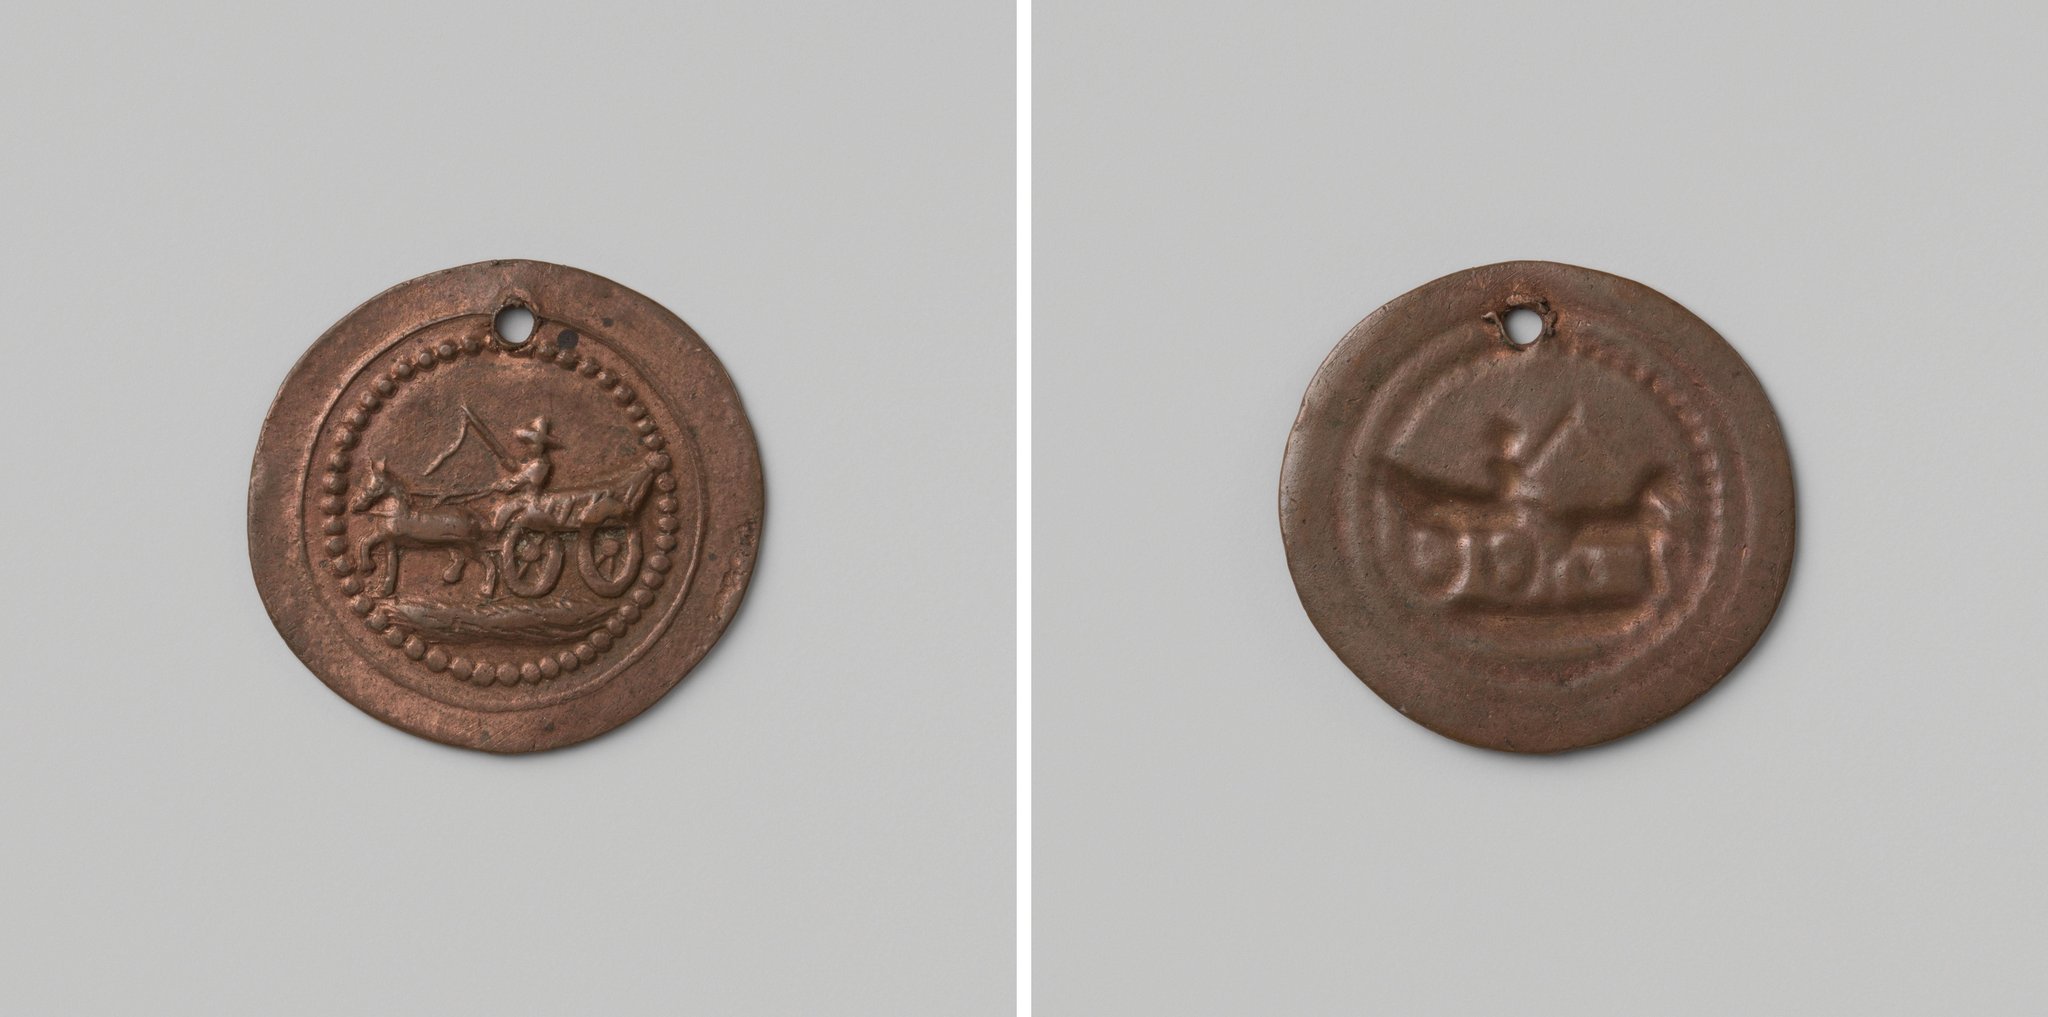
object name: medal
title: Penning met afbeelding van boerenwagen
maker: Anonymous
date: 1650-1850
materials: copper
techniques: striking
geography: netherlands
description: Eenzijdige koperen penning met gat erin. Voorzijde: naar links rijdende boerenkar, getrokken door twee paarden; op kar: man met hoed op hoofd en zweep in hand binnen parelrand. Keerzijde: blanco